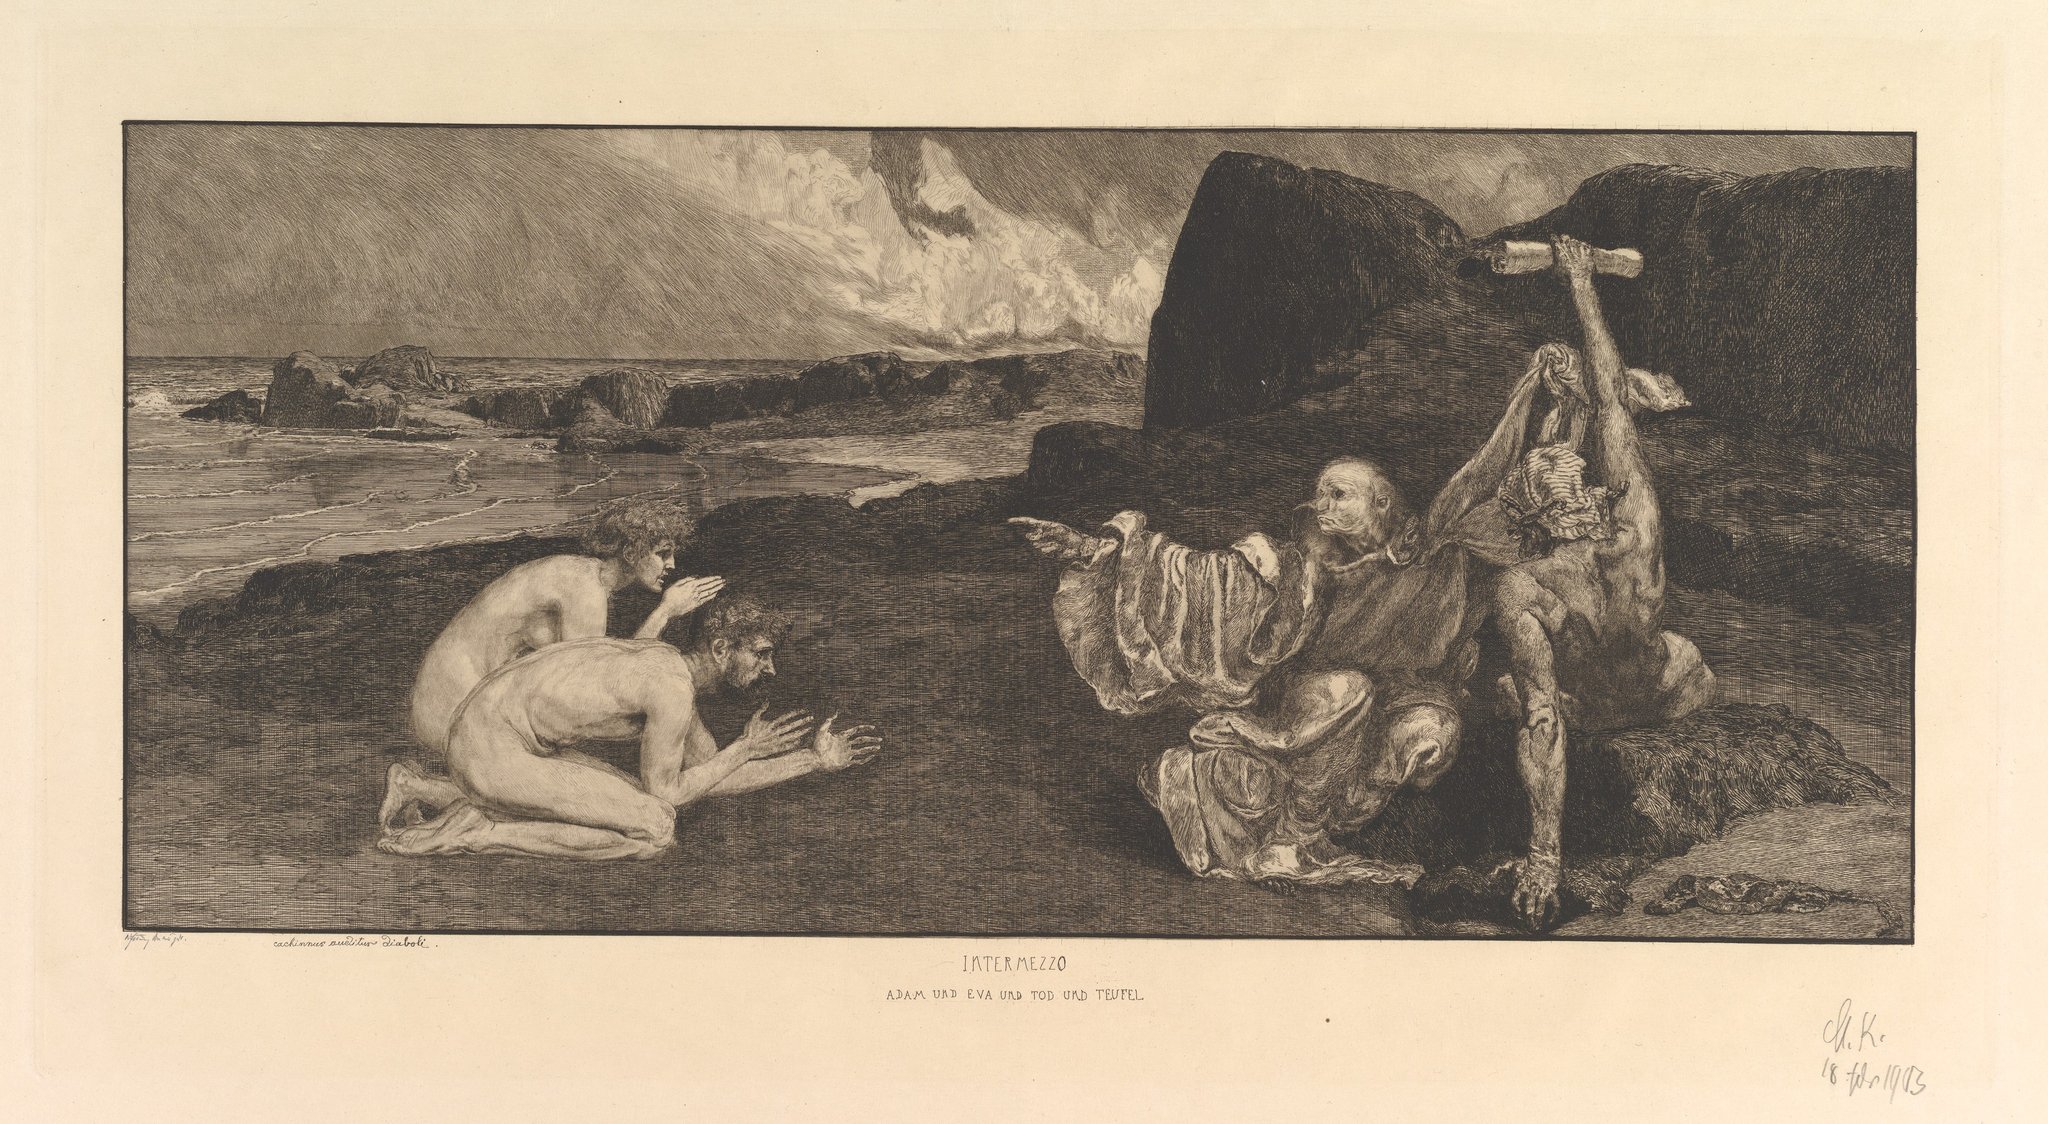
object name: print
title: Intermezzo (from the series A Love)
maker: max klinger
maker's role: artist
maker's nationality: german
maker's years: 1857-1920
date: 1887-1903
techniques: engraving, etching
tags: male nudes